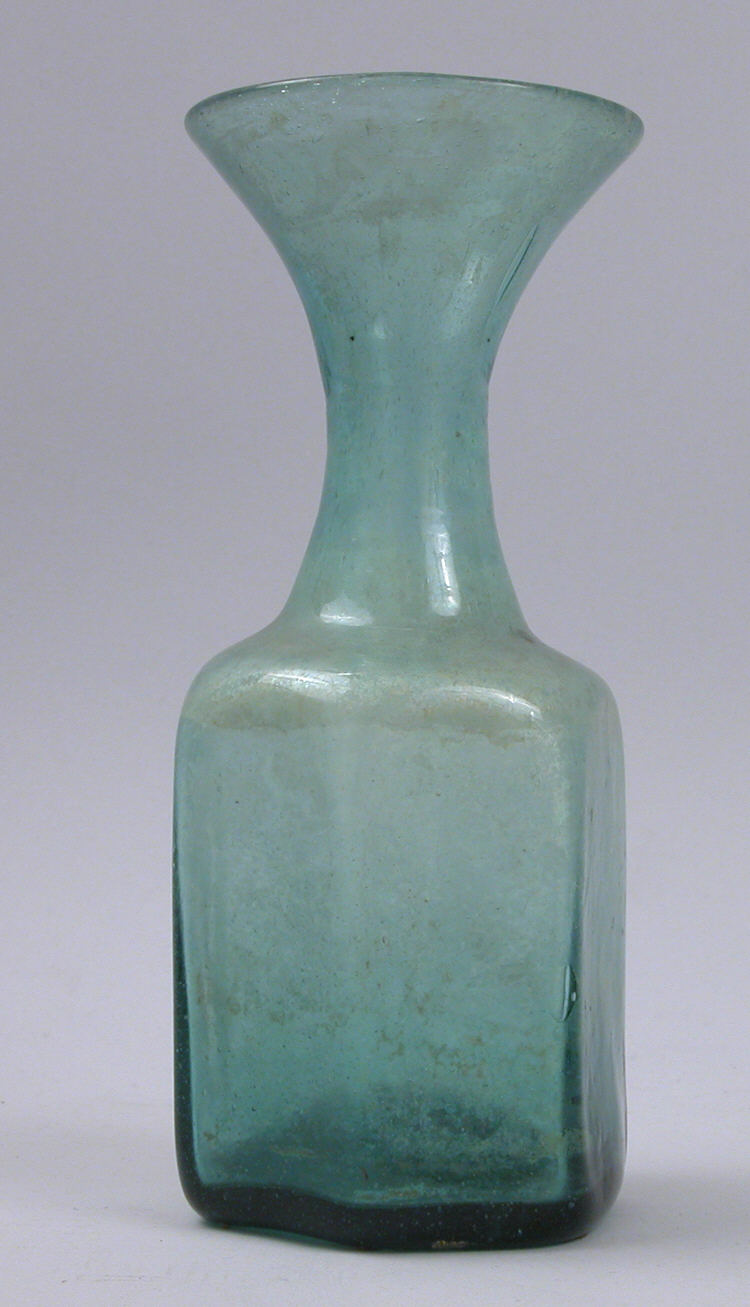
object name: bottle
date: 1701-1900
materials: glass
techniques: glassblowing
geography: iran